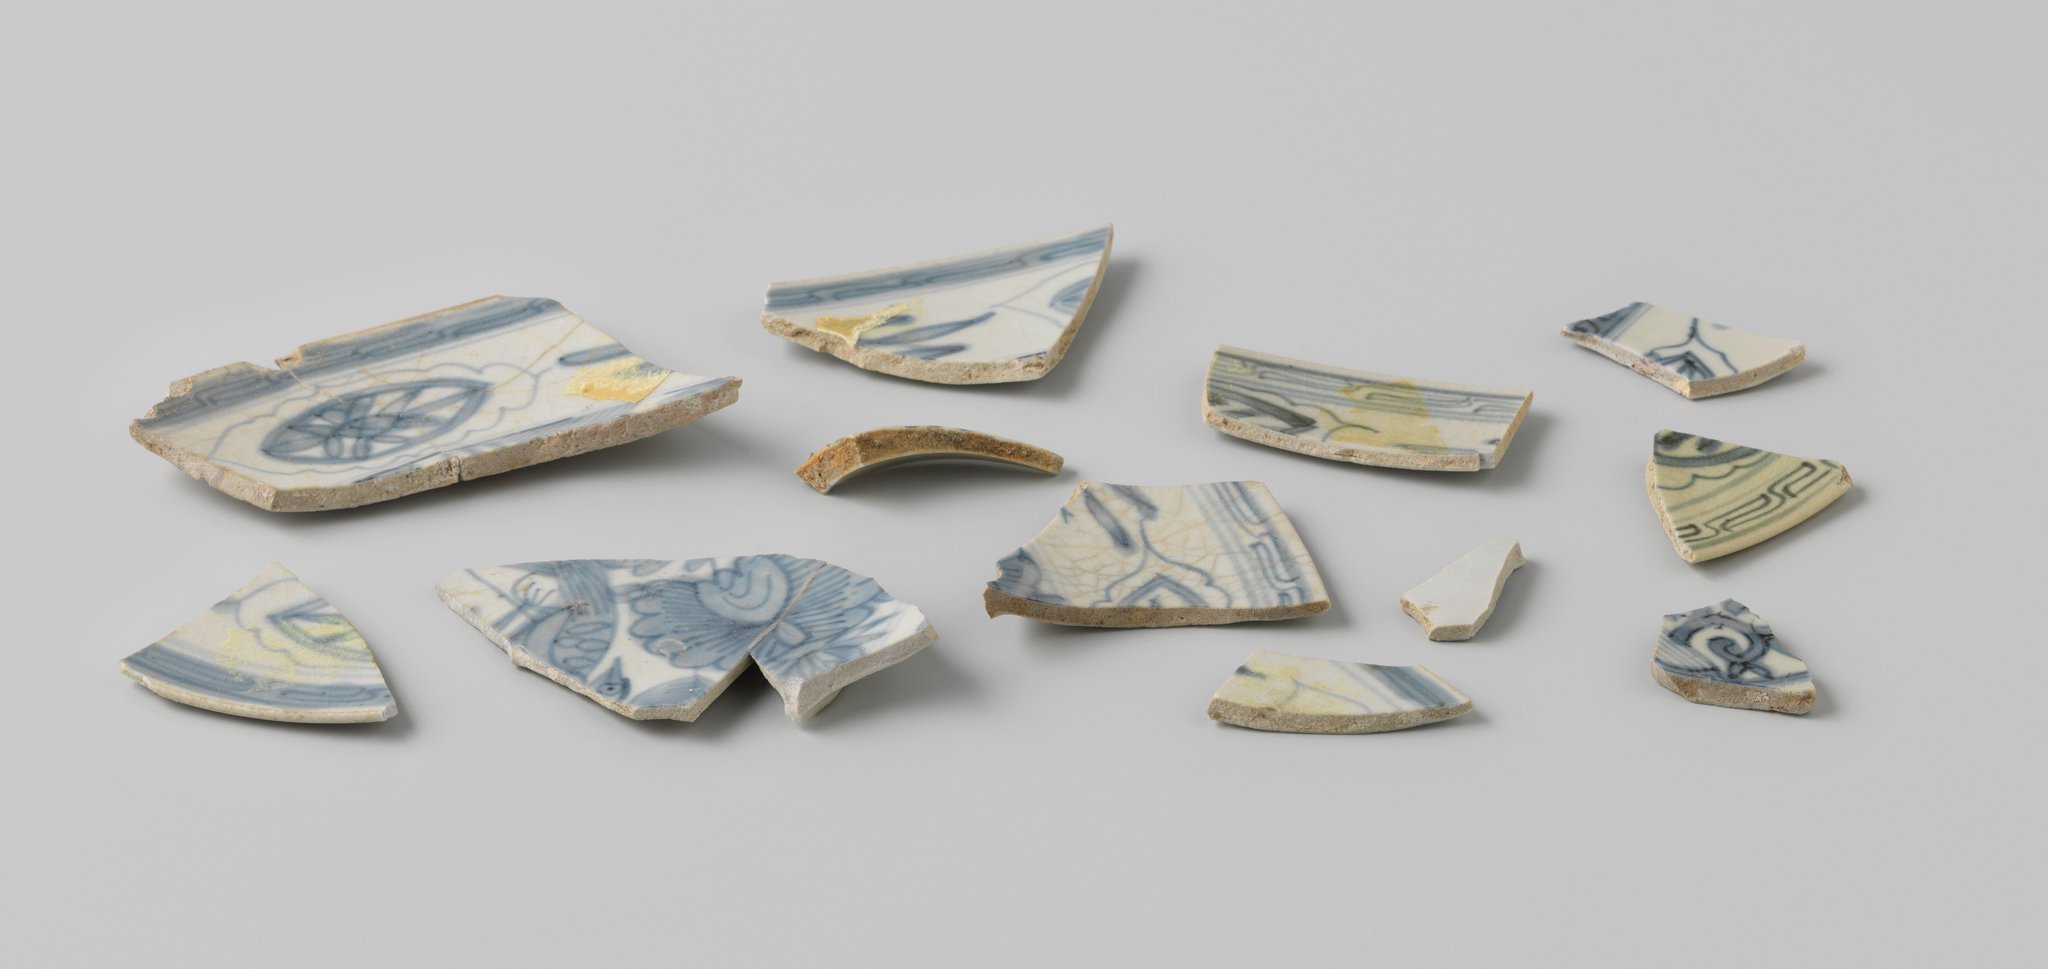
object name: sherd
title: Scherven van borden uit V.O.C.-schip de 'Witte Leeuw'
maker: Anonymous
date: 1613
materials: porcelain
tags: verenigde oostindische compagnie, sint-helena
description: Scherven van borden uit V.O.C.-schip de 'Witte Leeuw'.